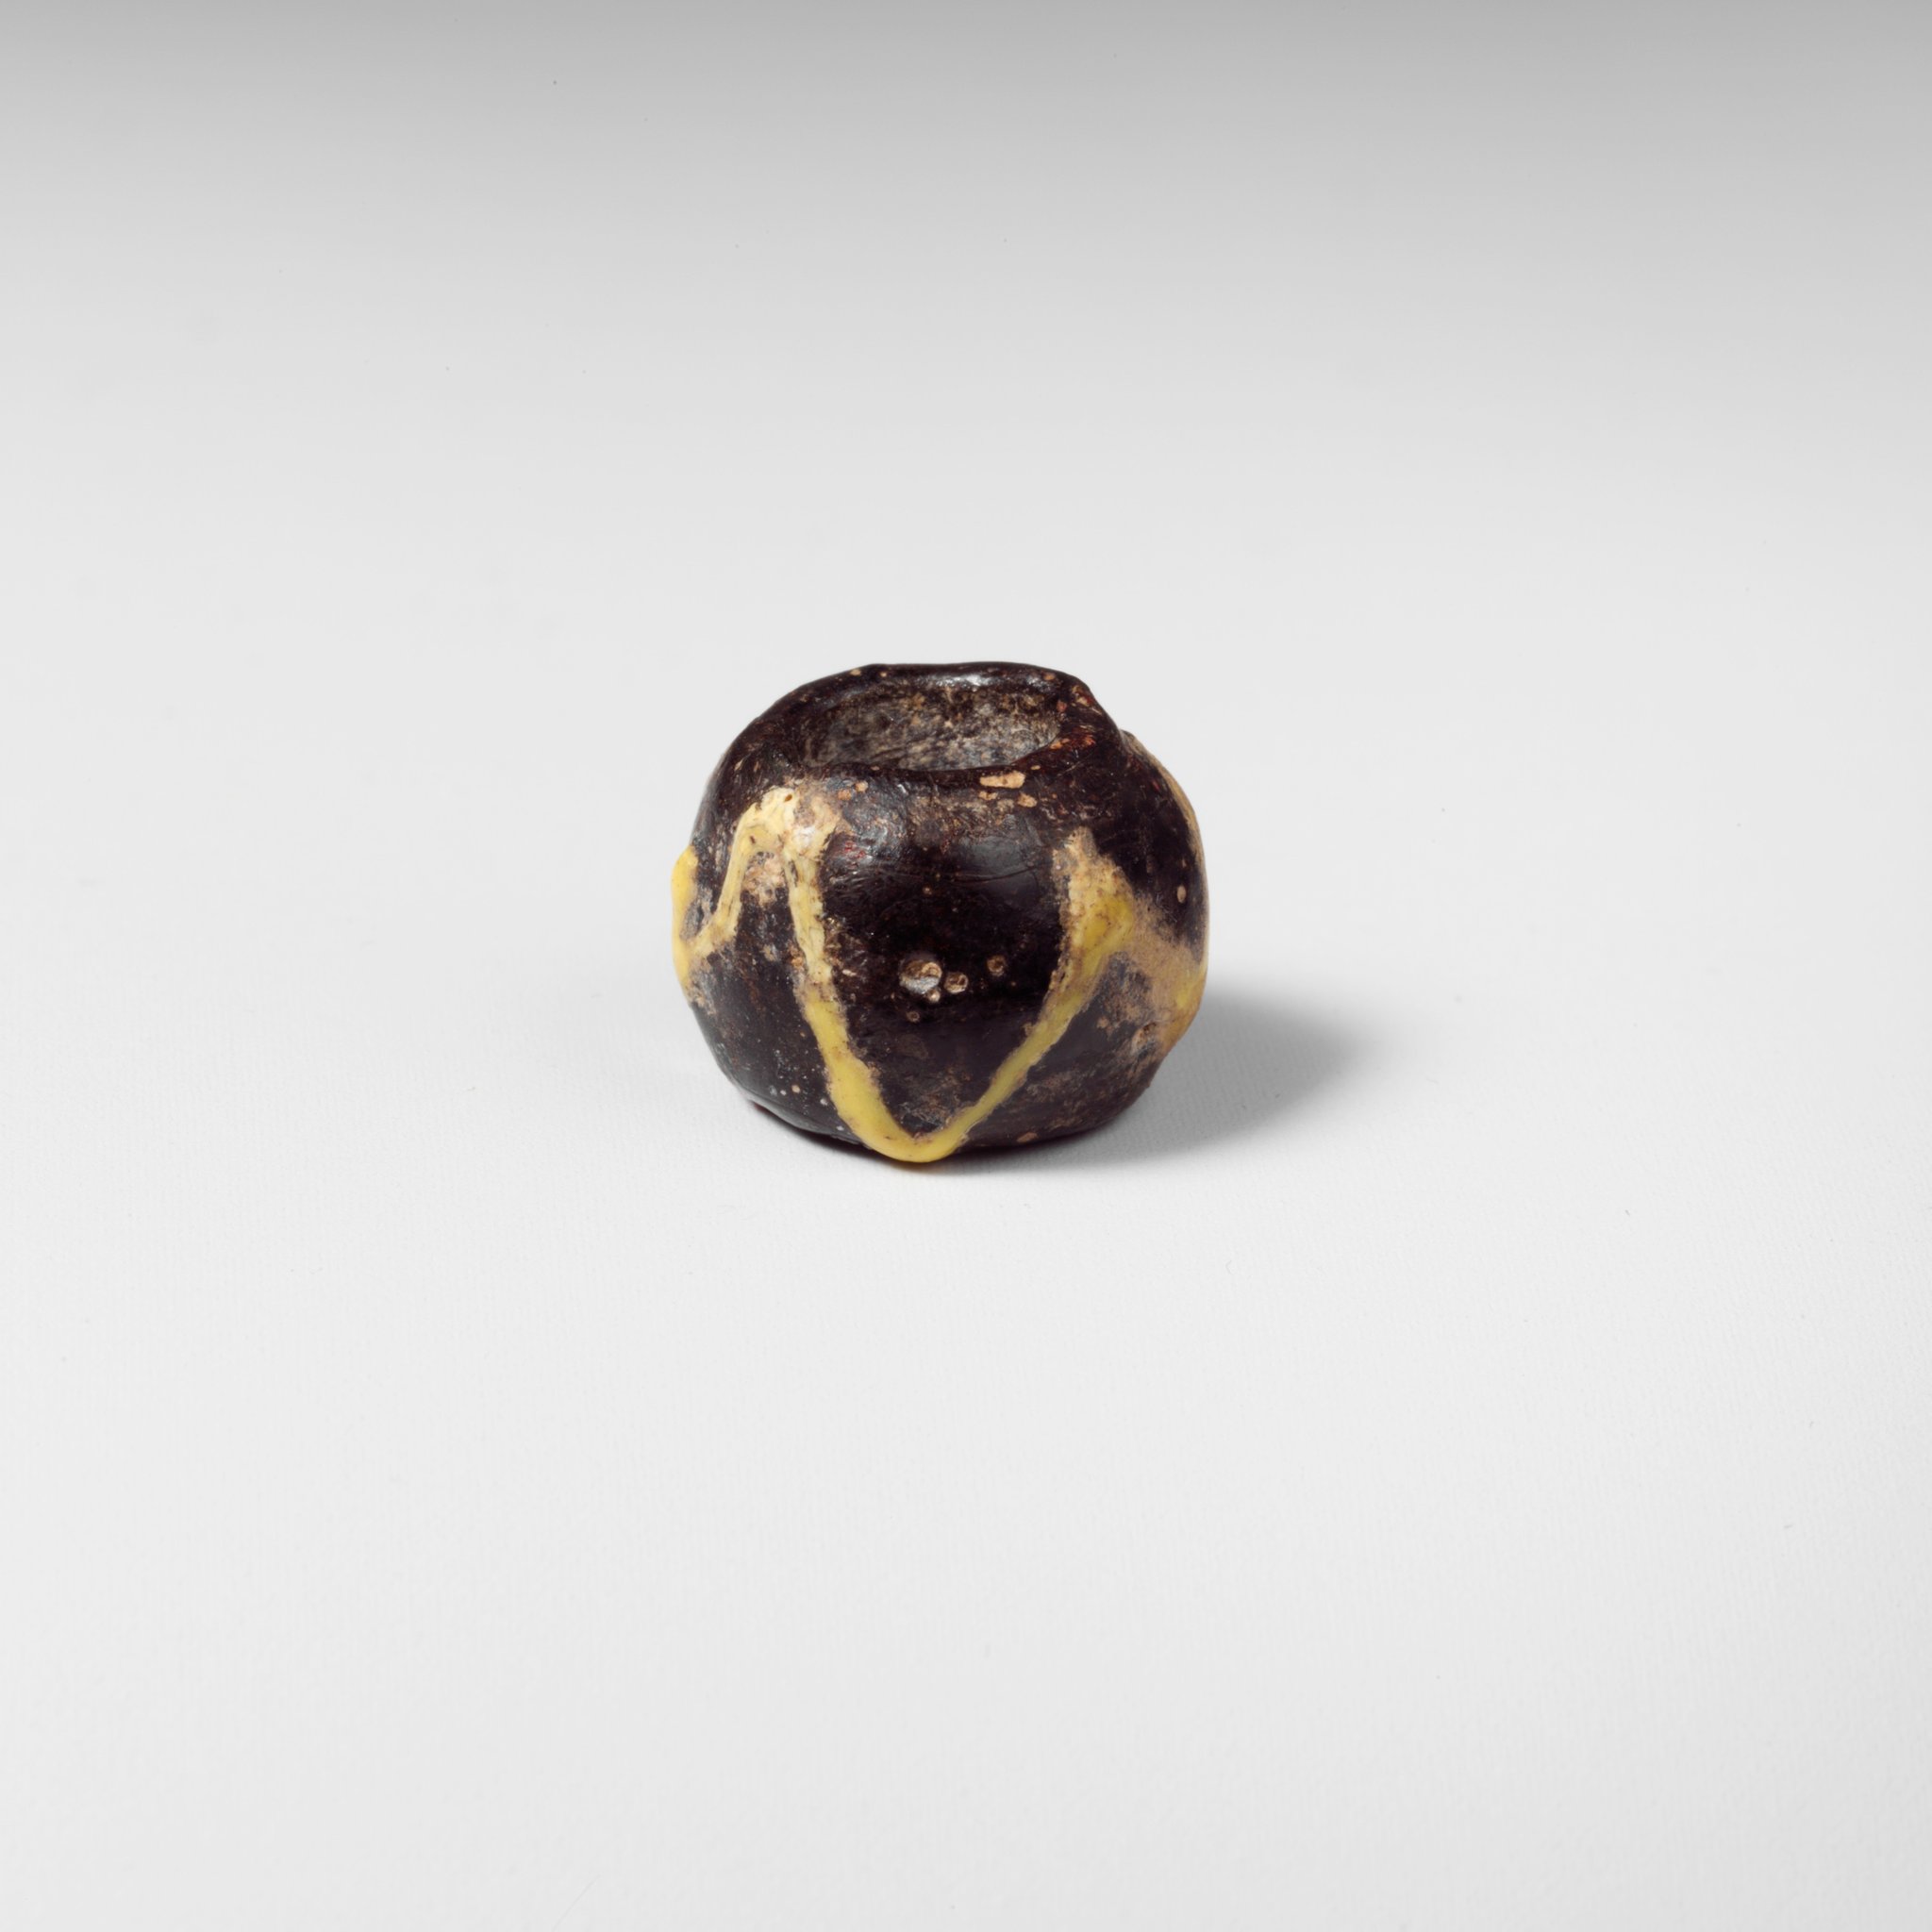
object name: bead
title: Glass bead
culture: byzantine or roman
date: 301-600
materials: glass